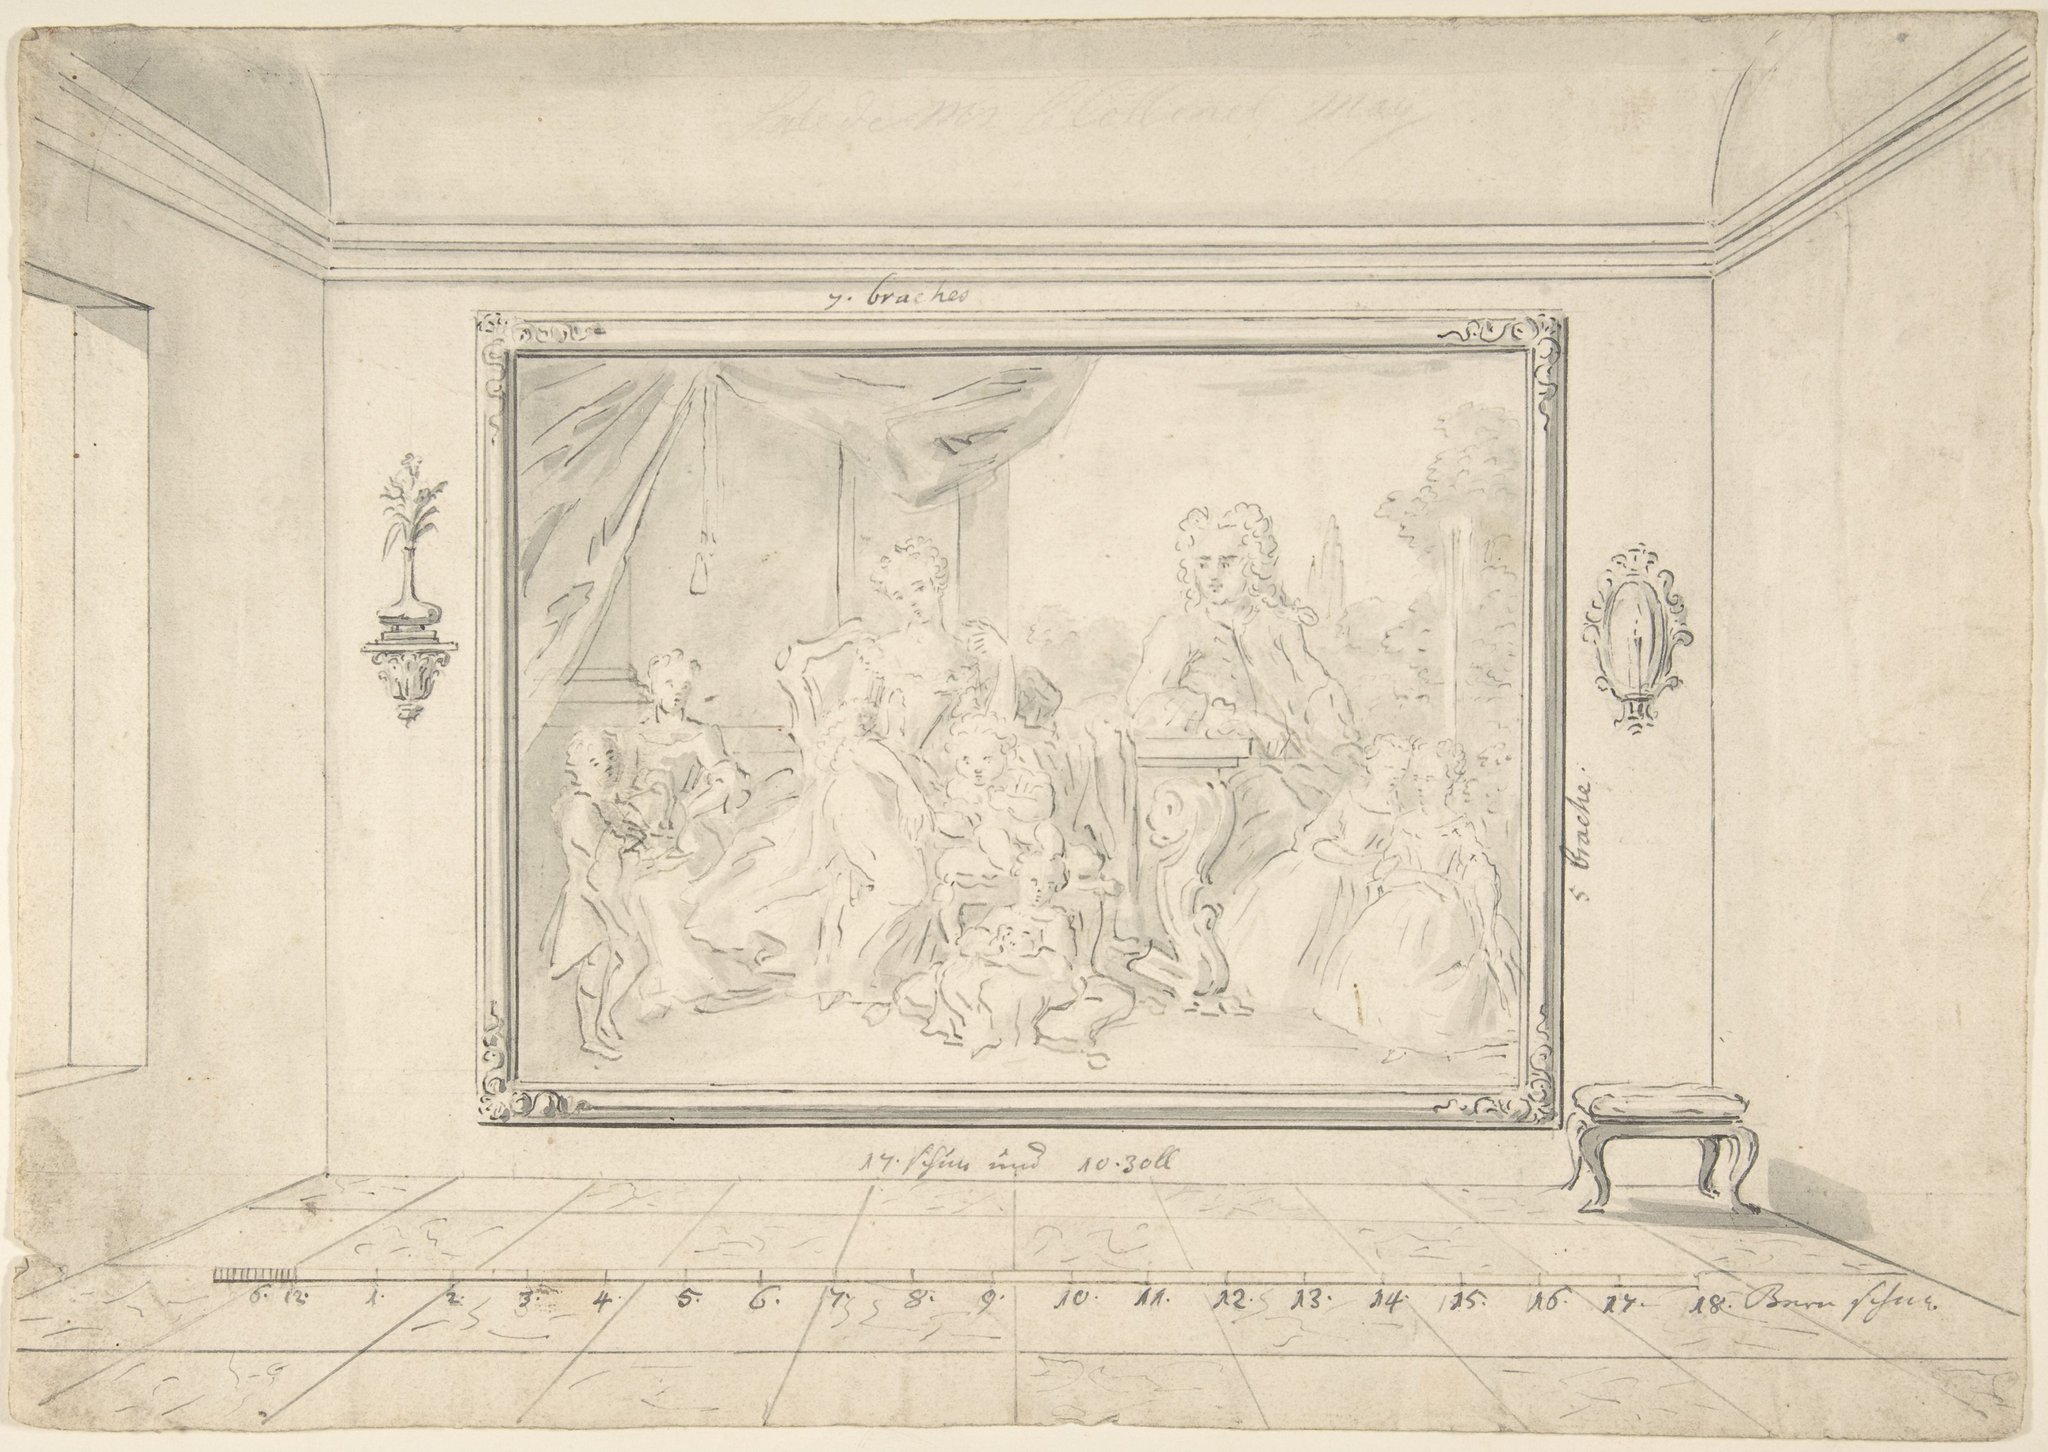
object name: drawing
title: Sketch of a Painted Family Portrait "in situ"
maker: anonymous, german, 19th century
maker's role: artist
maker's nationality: german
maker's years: 1800-1899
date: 1801-1900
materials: chalk, ink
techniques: brush, pen, wash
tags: interiors,portraits,family,stools